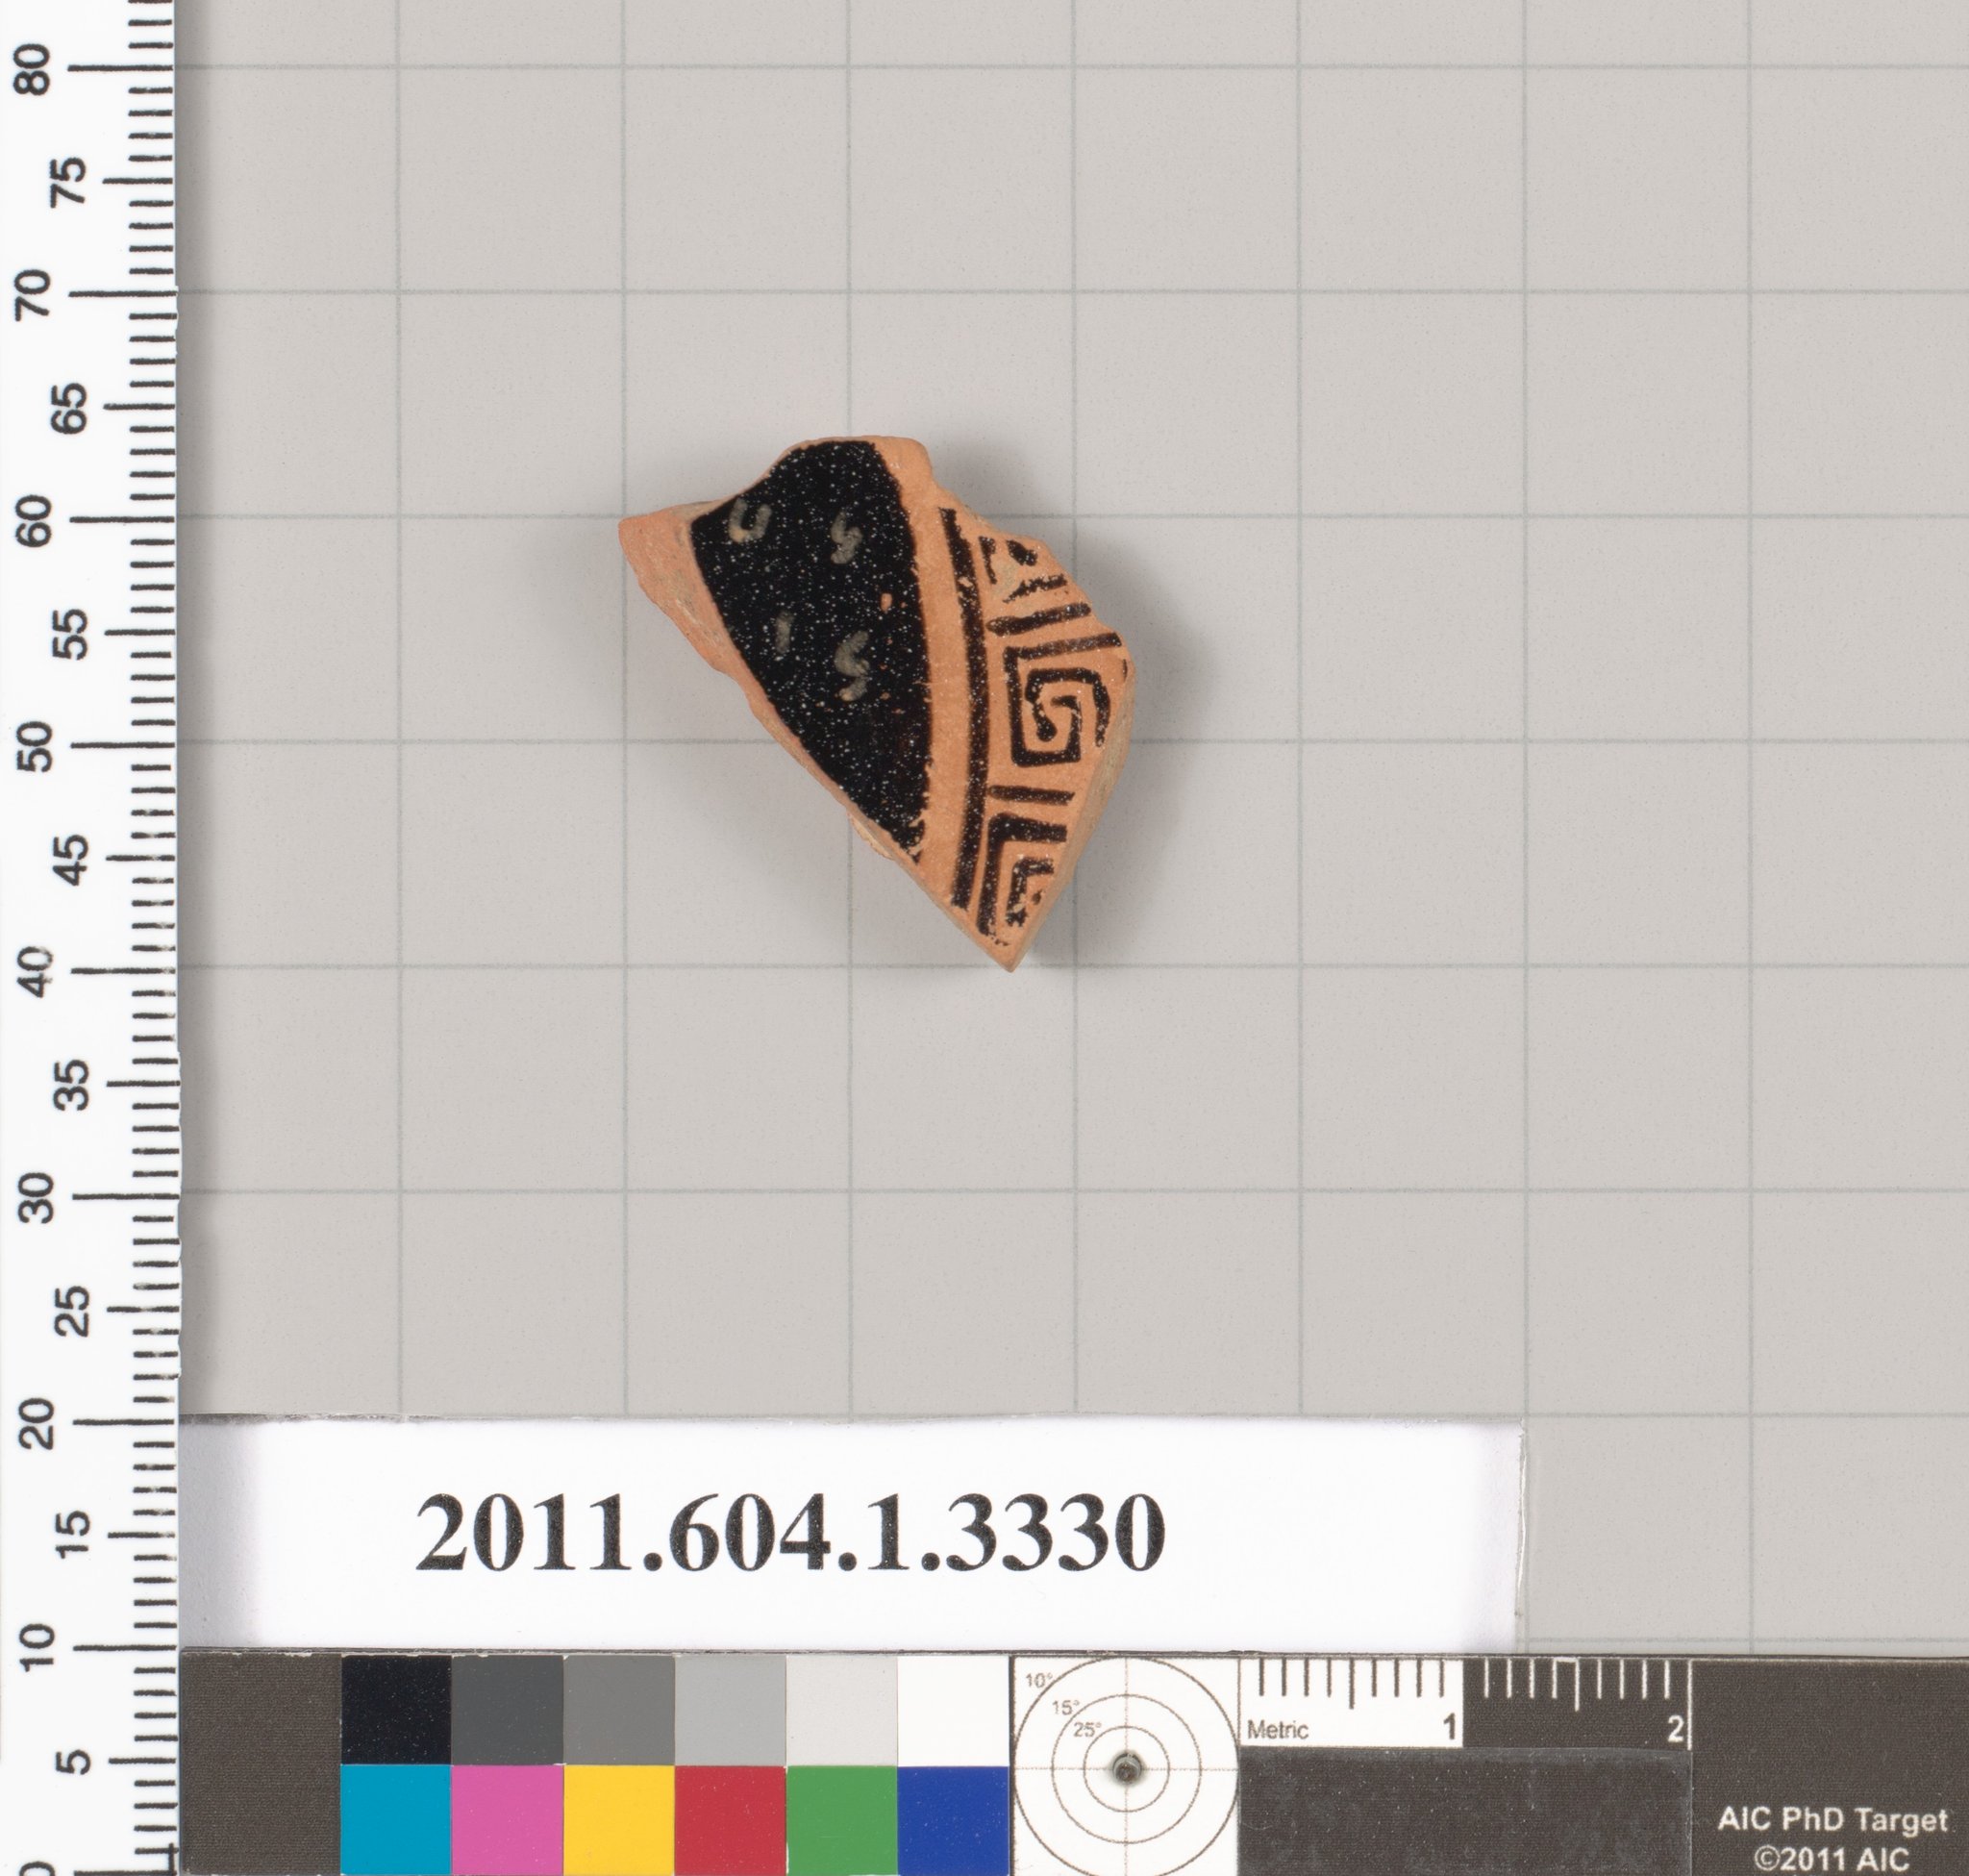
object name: kylix fragment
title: Terracotta fragment of a kylix (drinking cup)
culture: greek, attic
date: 475-451 BCE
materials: terracotta